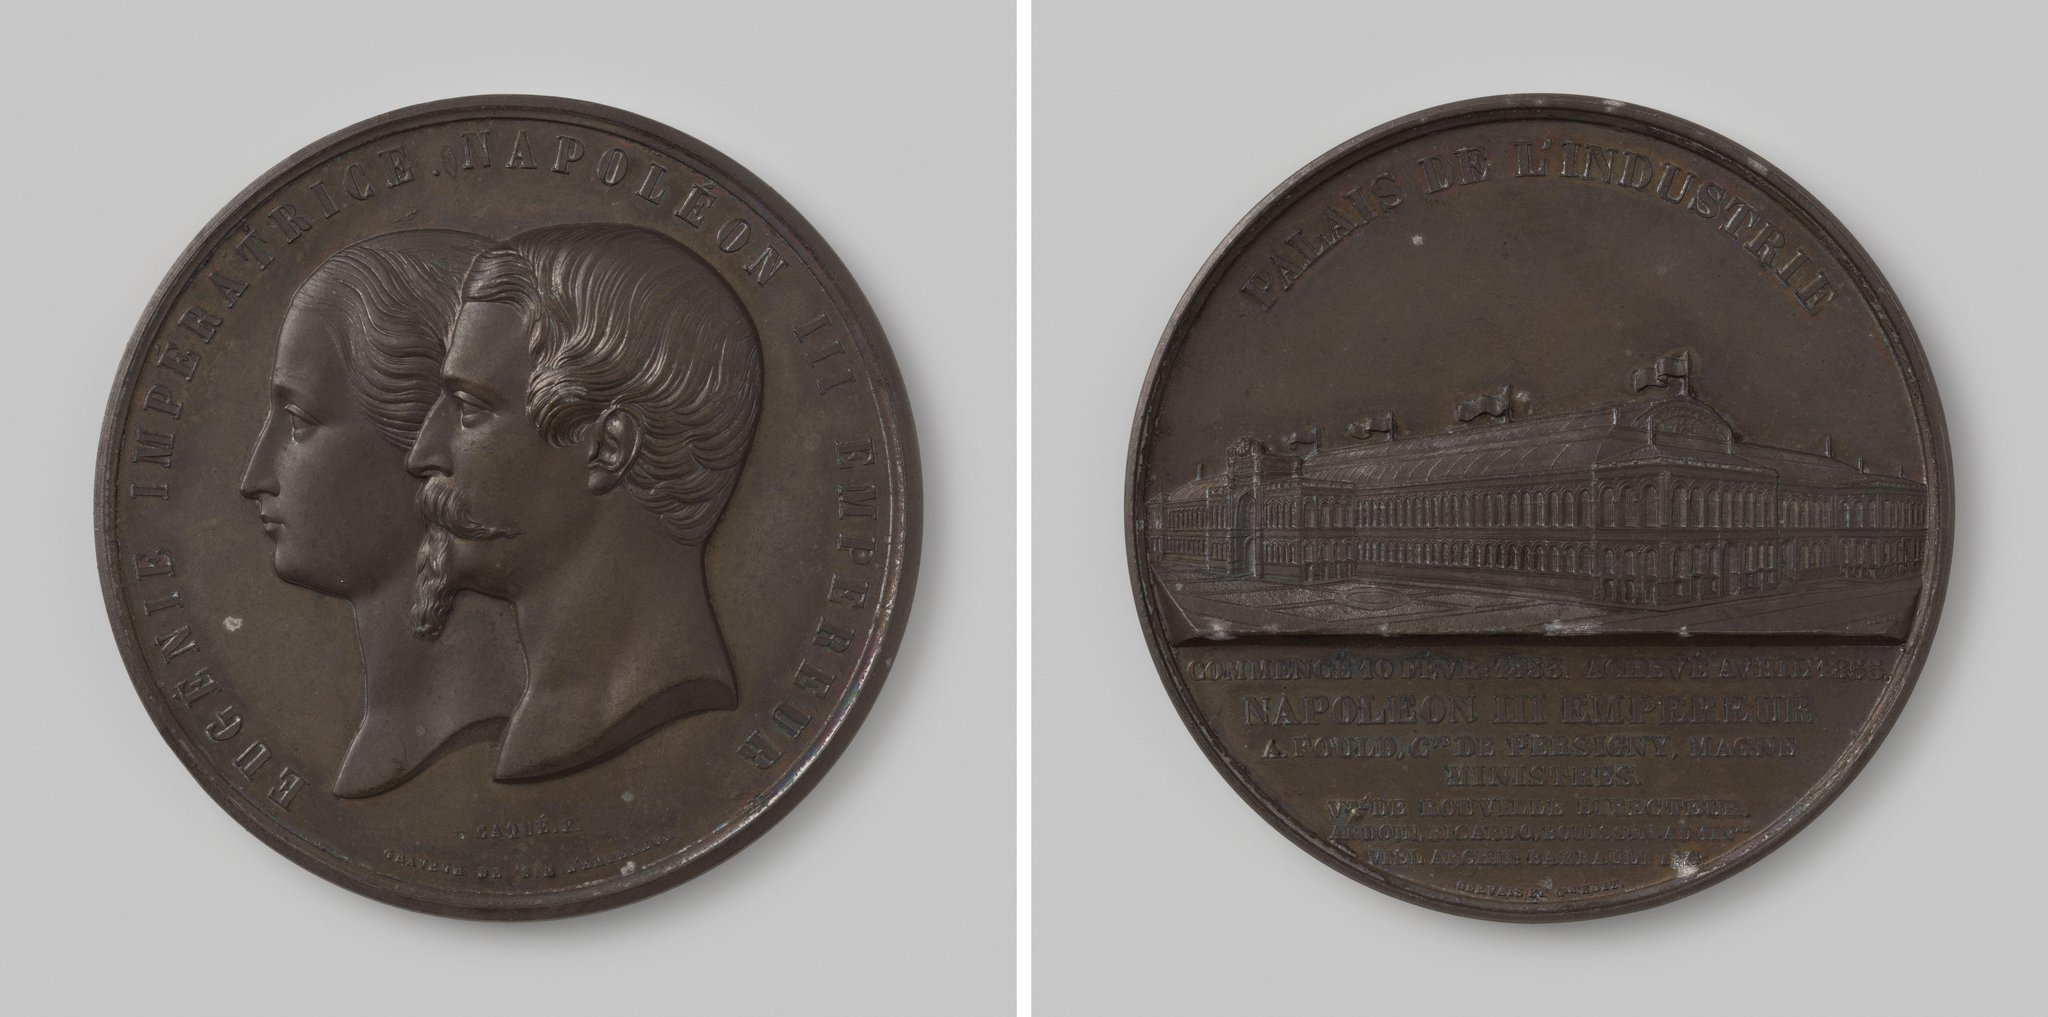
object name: history medal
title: Opening van het Palais de l'Industrie te Parijs 1855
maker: armand auguste caqué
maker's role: print maker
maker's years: 1795-1881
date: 1855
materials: bronze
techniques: striking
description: Bronzen penning, op de voorzijde de geconjugeerde portretten van Keizer Napoleon III en Eugenie naar links met omschrift, op de keerzijde het aanzicht van het Palais d'Industrie met bovenaan omschrift en onderaan zeven regels afsnedetekst.